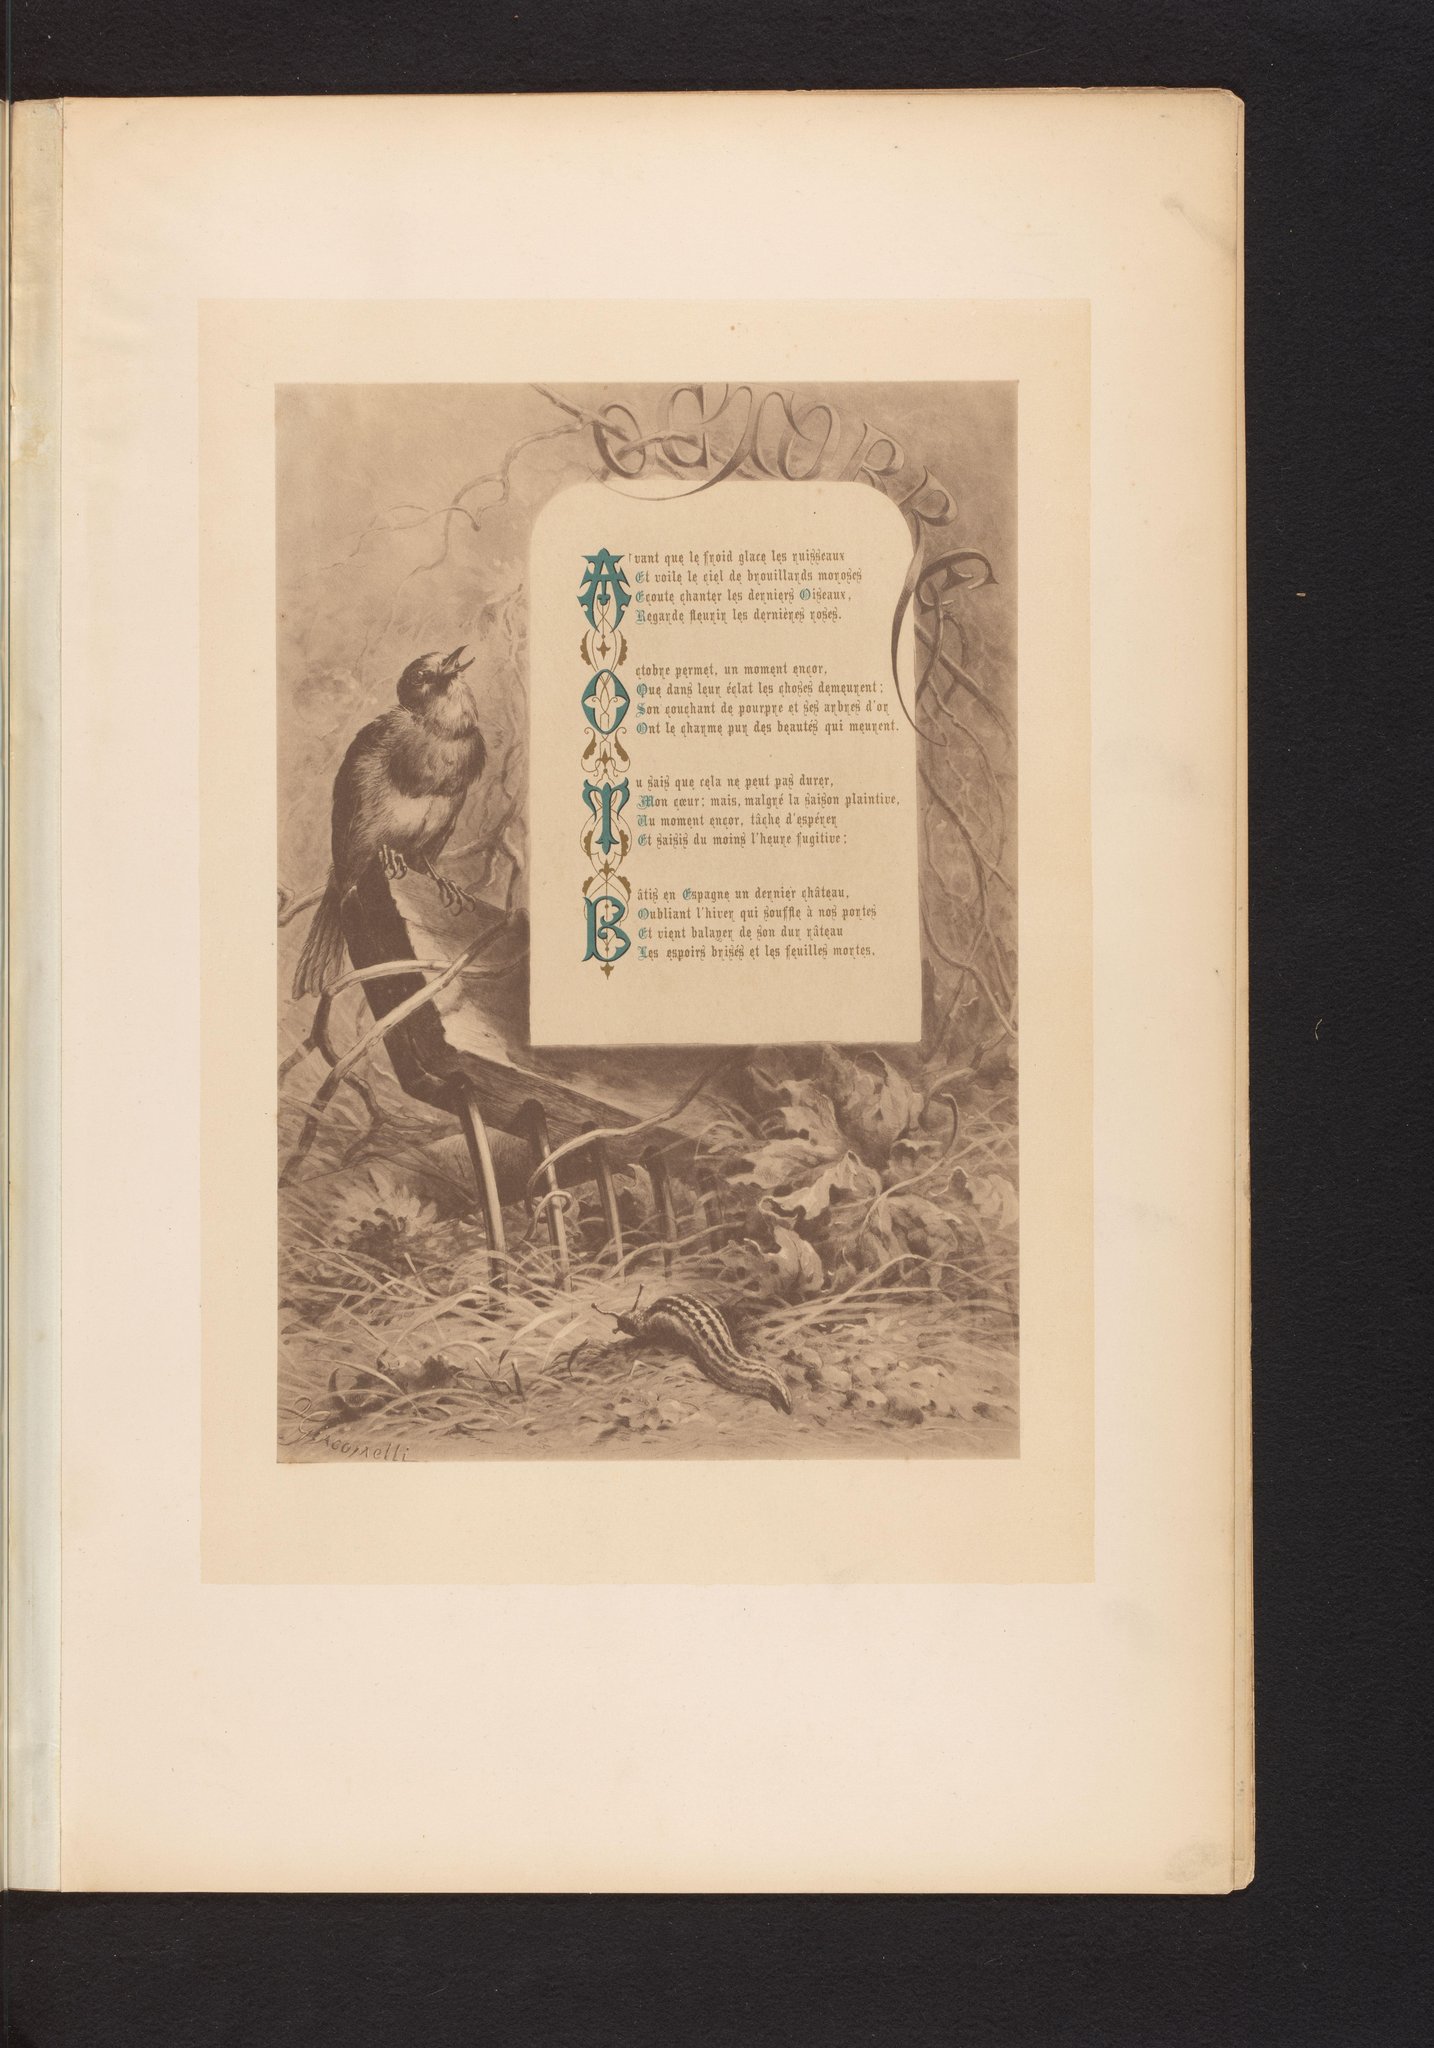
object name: reproduction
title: Reproductie van een prent van een vogel op een hark en een slak, met het gedicht Octobre van François Coppée, door Hector Giacomelli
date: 1871-1876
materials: paper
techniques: chromolithography, photograph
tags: birds, molluscs: snail, october ~ other concepts, agricultural implements: rake